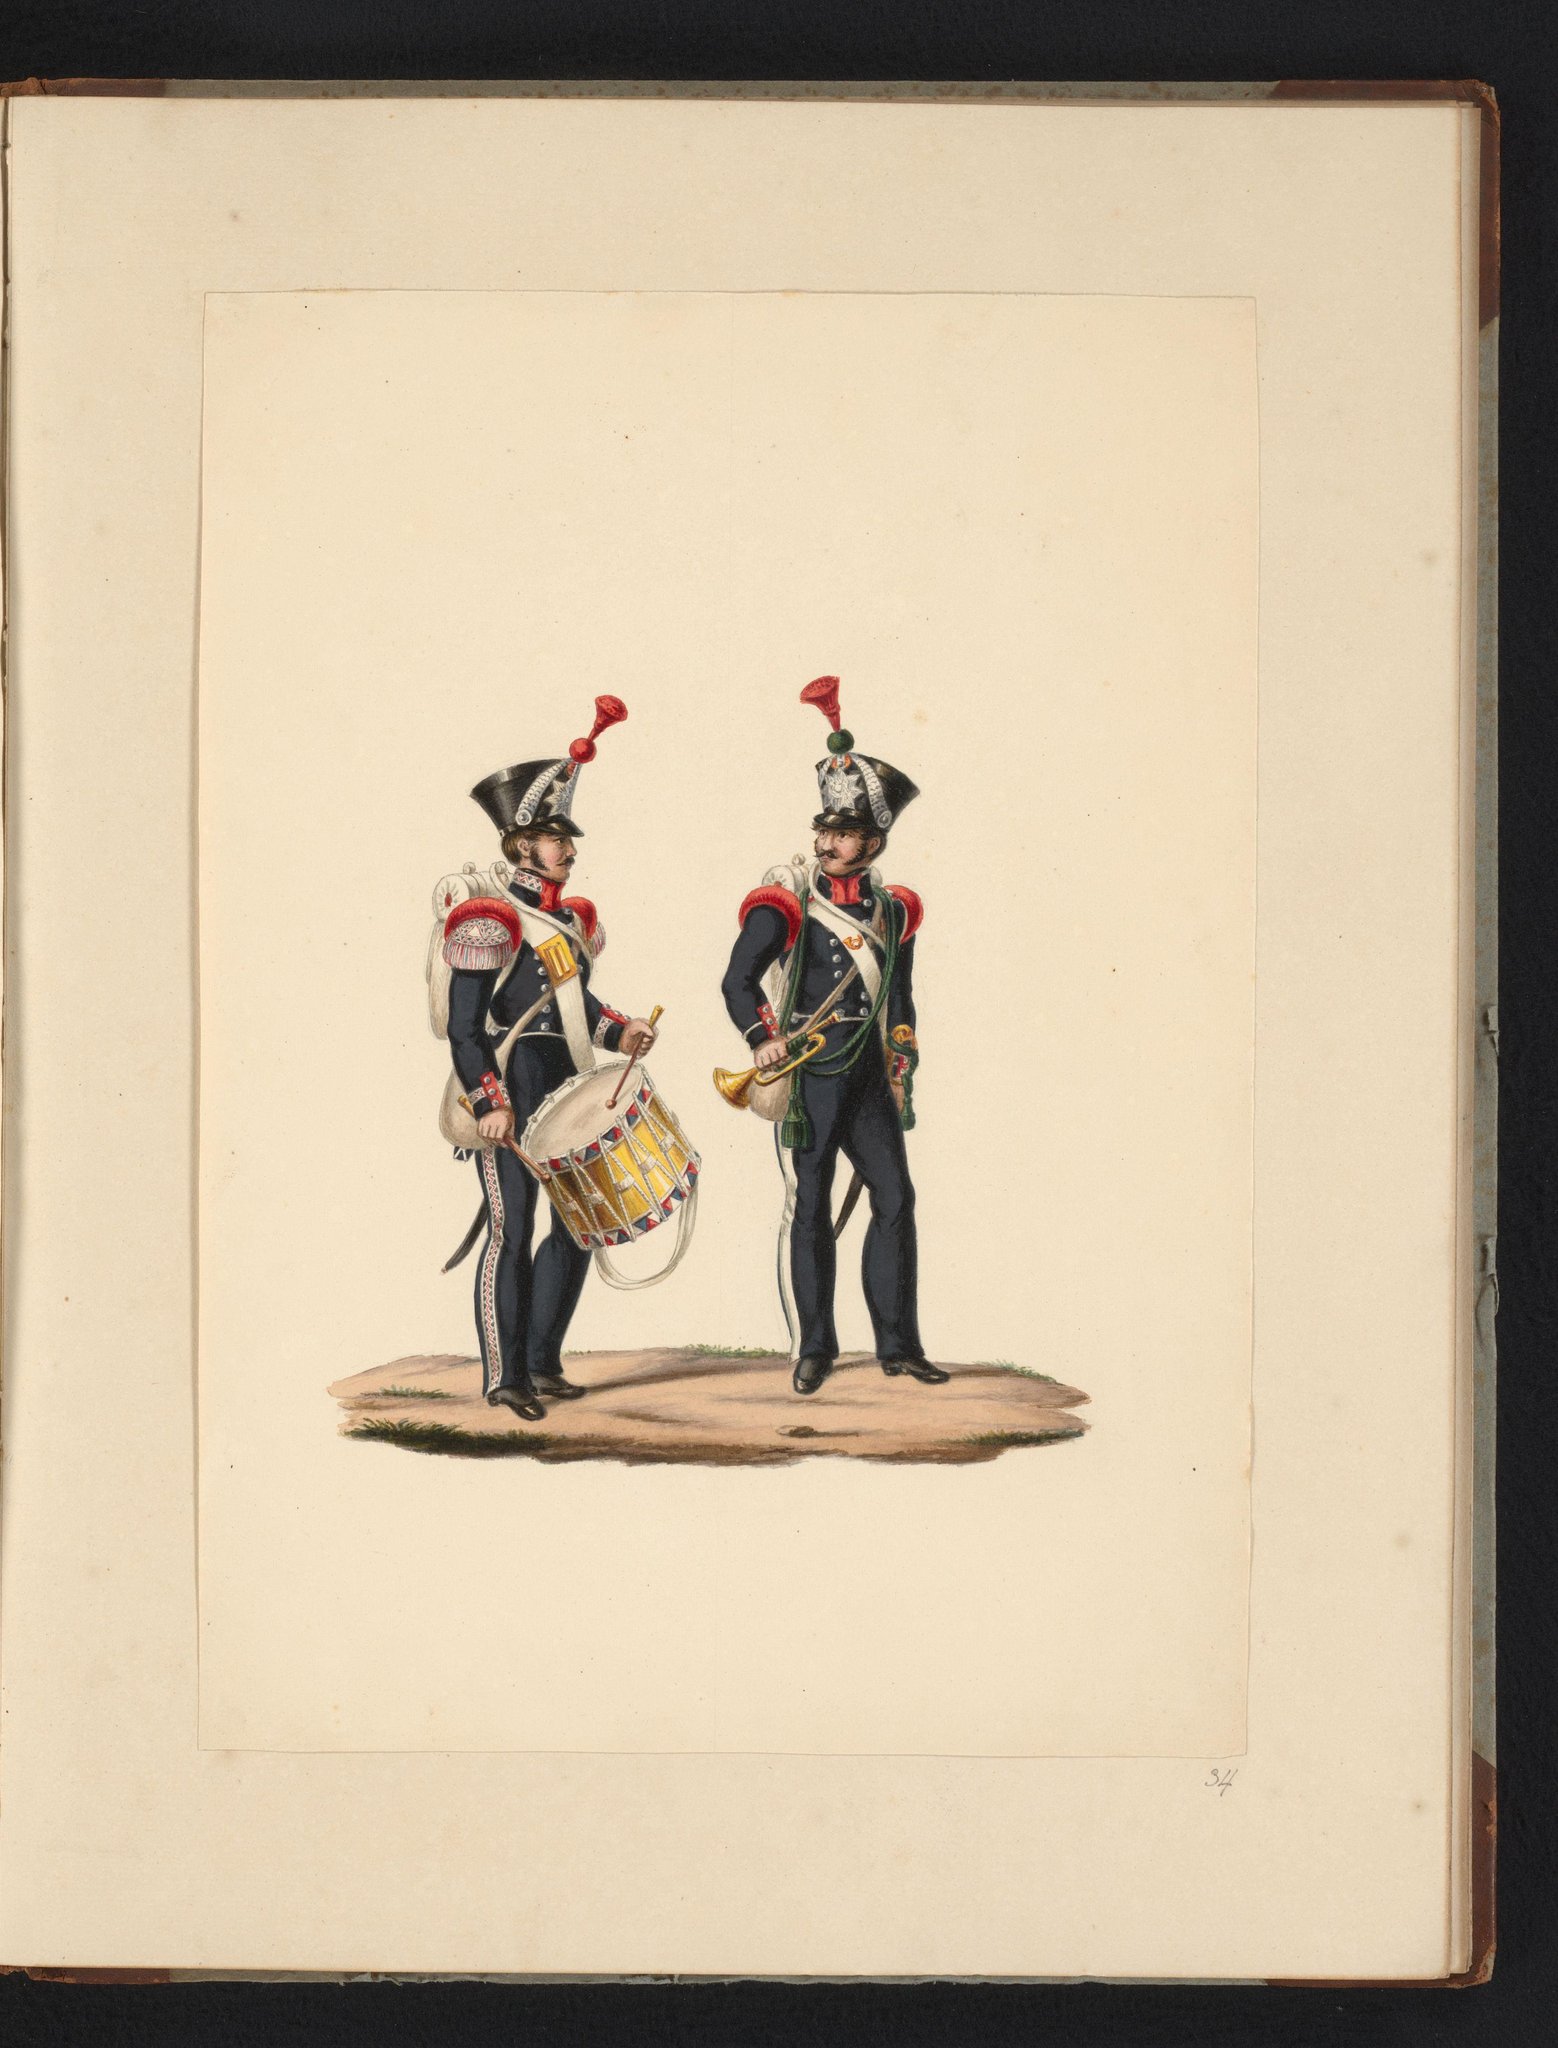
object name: drawing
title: Tamboer en trompetter van de mobiele schutterij, 1830-1831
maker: Anonymous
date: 1831-1832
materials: paper, pencil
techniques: brush, lacquer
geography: netherlands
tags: professional clothes, (military) uniforms, netherlands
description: Een tamboer en een trompetter van de mobiele schutterij, te voet. Onderdeel van het album met 39 ingeplakte tekeningen van militairen van de Koninklijke Nederlandsche Armee uit 1830-1831.